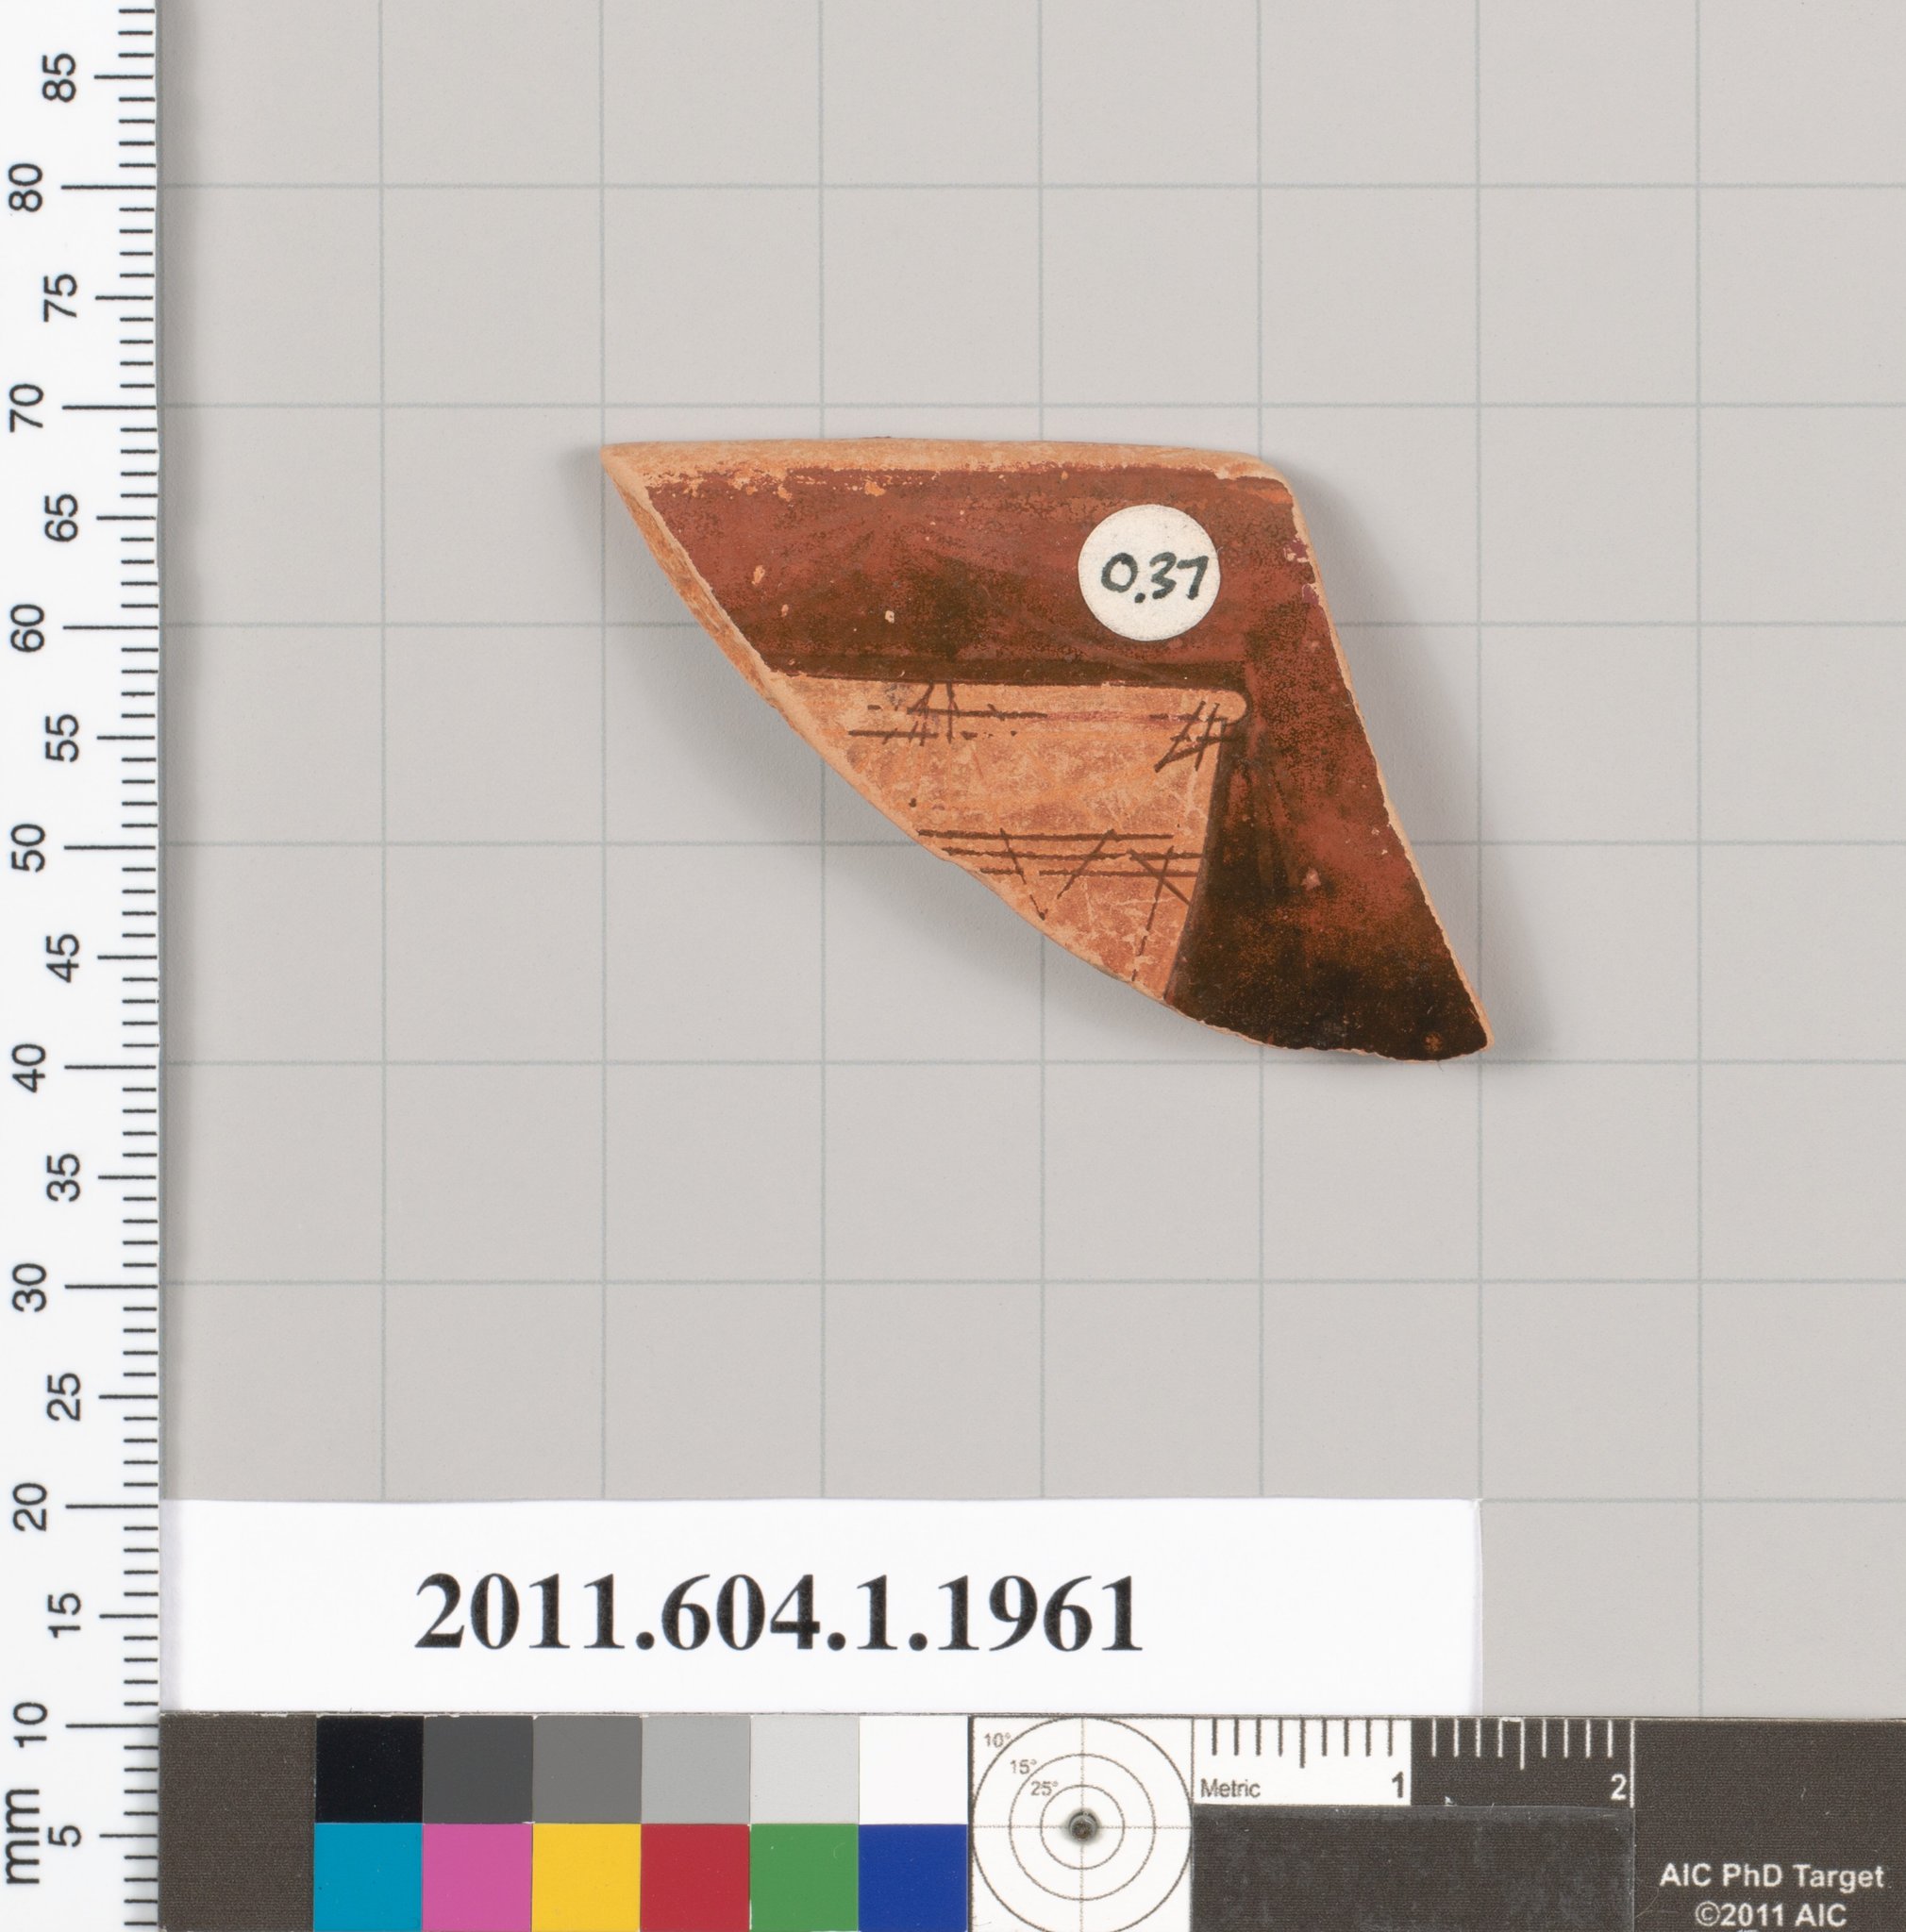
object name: kylix fragment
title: Terracotta rim fragment of a kylix (drinking cup)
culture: greek, attic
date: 490-480 BCE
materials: terracotta